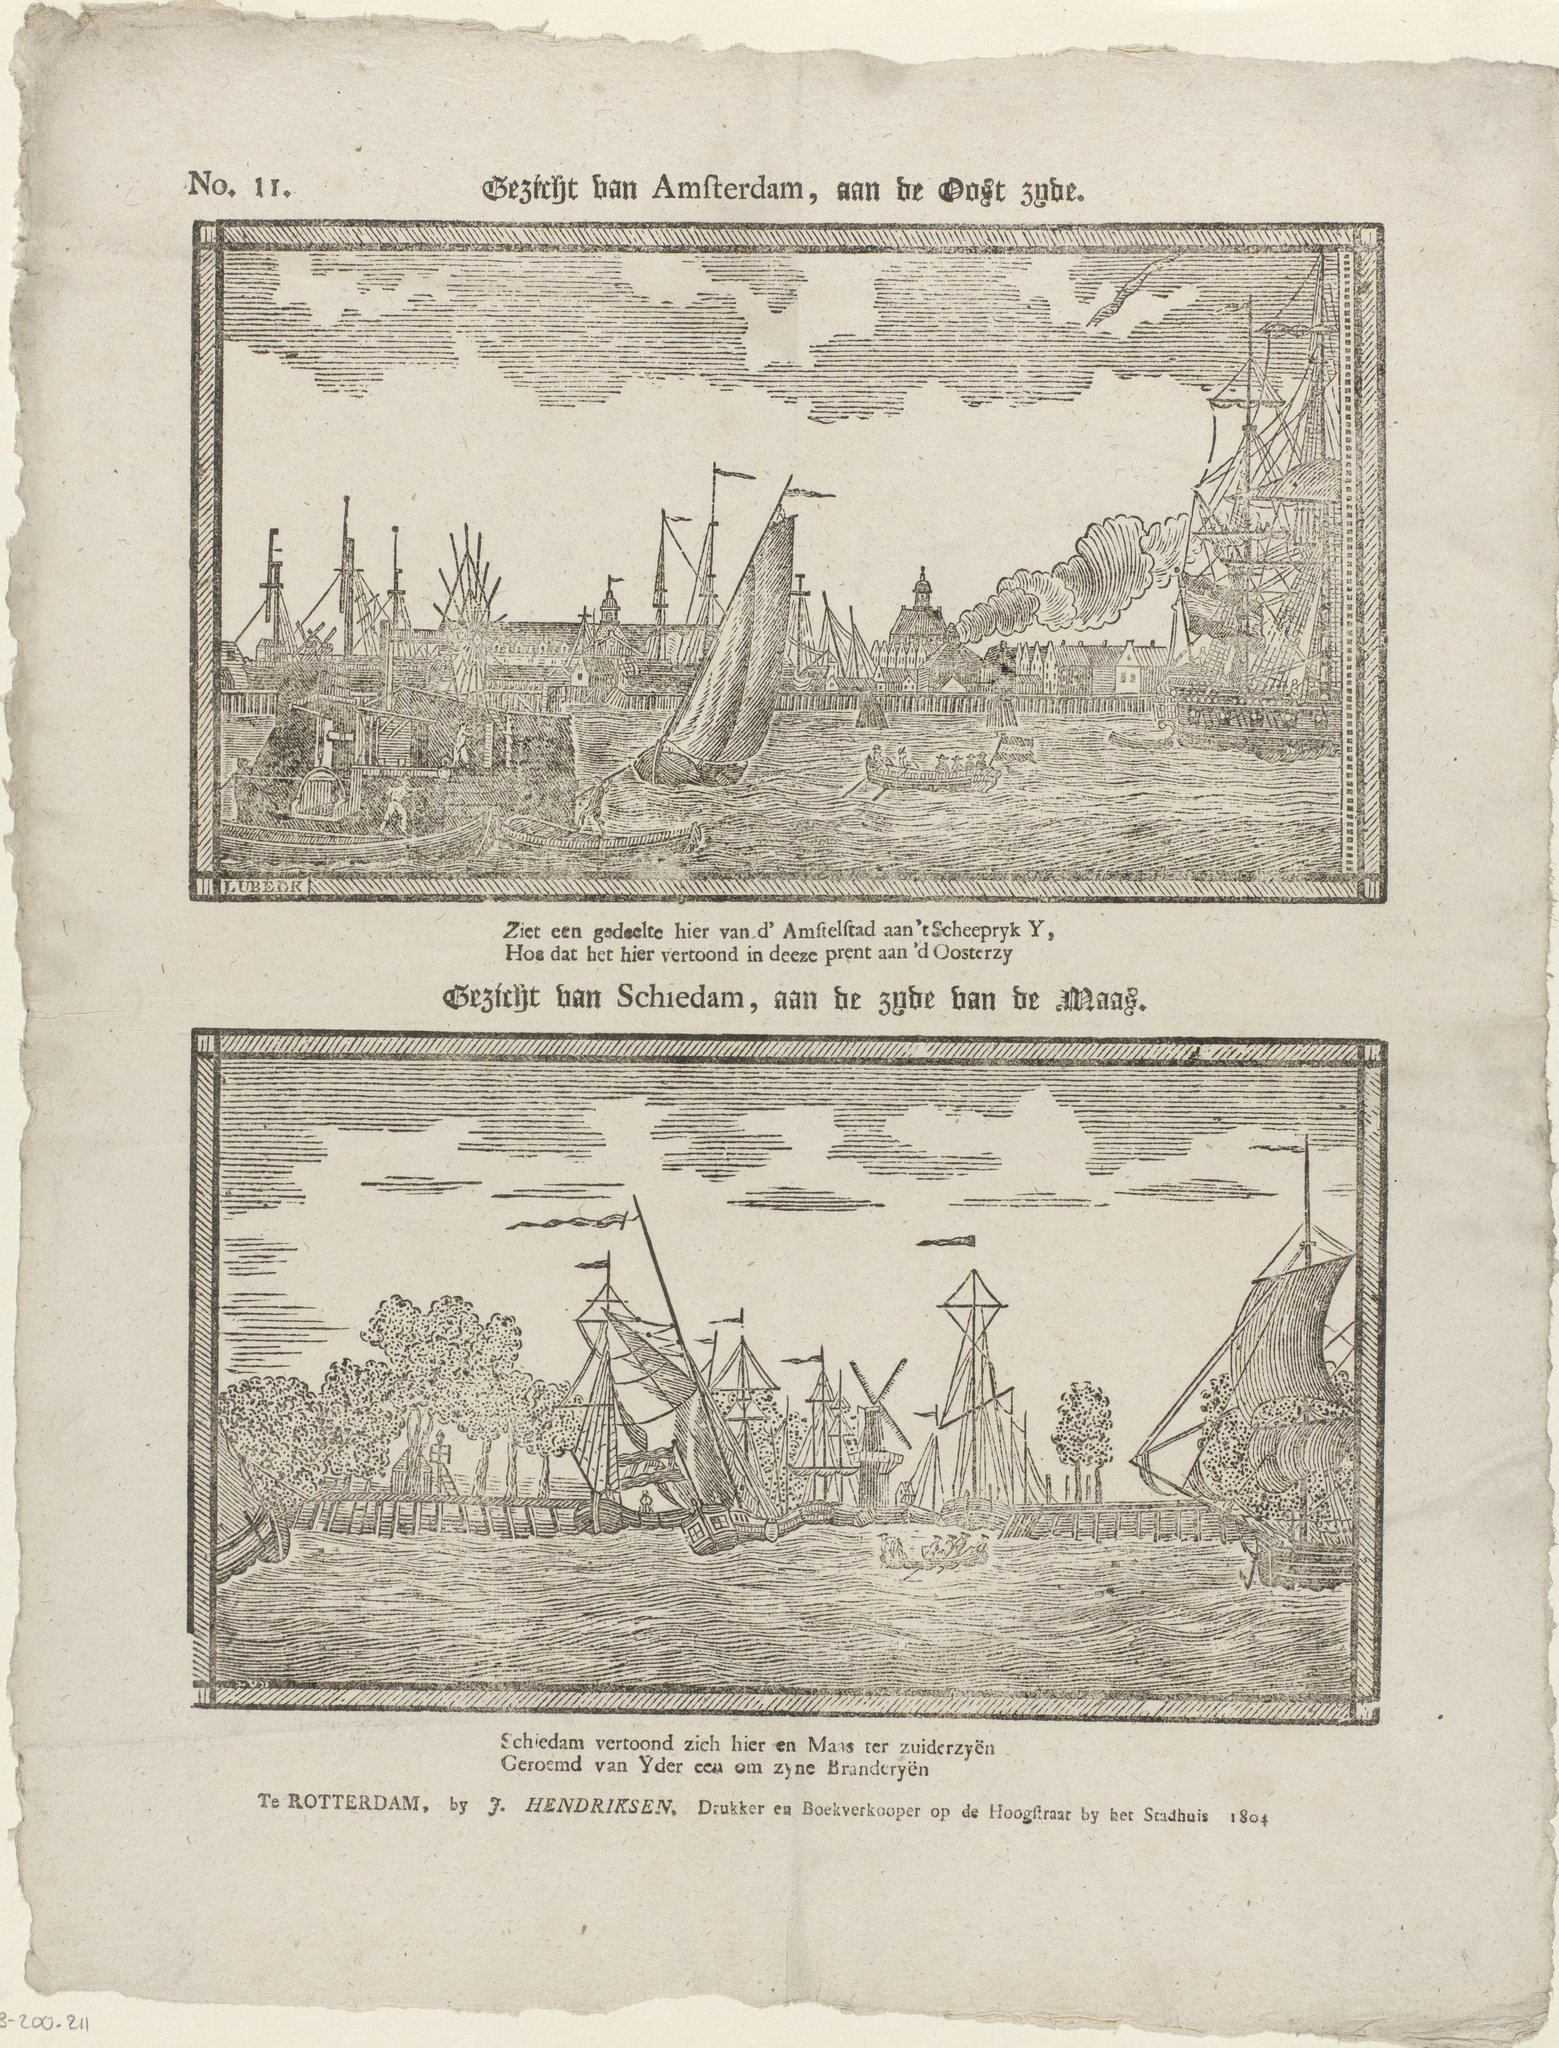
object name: popular print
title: Gezicht van Amsterdam, aan de oost zyde. / Gezicht van Schiedam, aan de zyde van de Maas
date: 1804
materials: paper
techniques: letterpress printing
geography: rotterdam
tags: ships (in general), amsterdam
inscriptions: collector's mark: Lugt 2760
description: Blad met 2 voorstellingen. Boven: een gezicht op Amsterdam. Onder: een gezicht op Schiedam vanaf de Maas gezien. Onder elke voorstelling een tweeregelig onderschrift. Genummerd linksboven: No. 11.